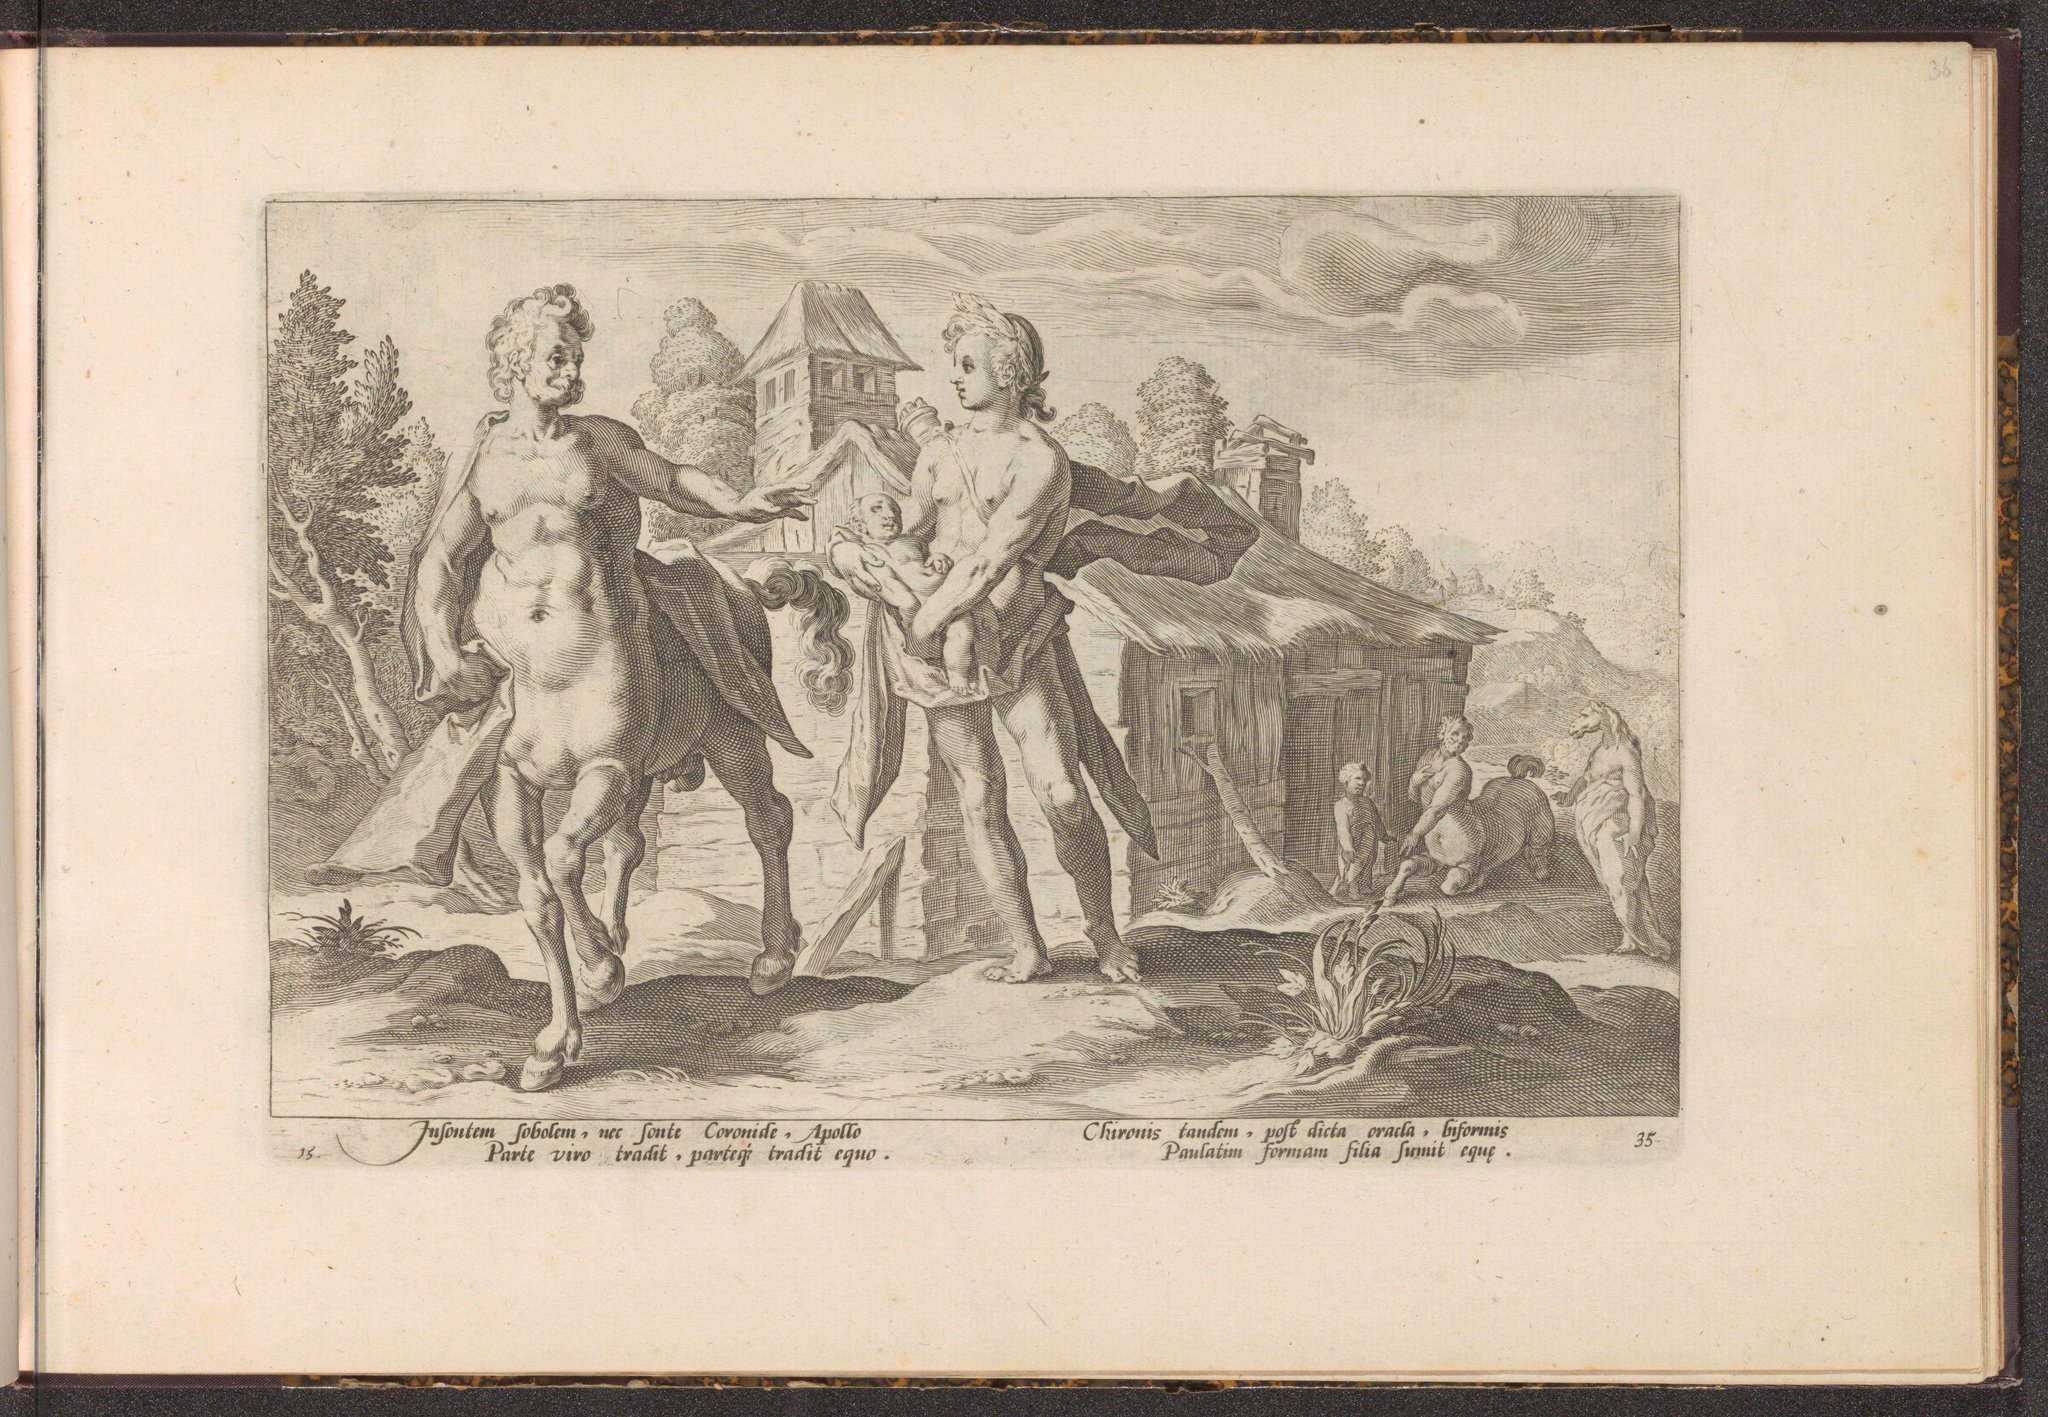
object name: album leaf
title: Herscheppingen van P. Ovidius Naso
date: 1590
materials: paper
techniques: engraving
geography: haarlem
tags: apollo hands aesculapius over to chiron, ocyroe changed into a mare: when she is foretelling the fates of her father chiron and the young aesculapius, ocyroe is changed into a mare (ovid, metamorphoses ii 657)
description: Apollo geeft zijn kind Asclepius, dat hij uit Coronis' buik heeft gesneden nadat hij haar heeft doodgeschoten, aan de centaur Chiron. Op de achtergrond is te zien hoe de dochter van Chiron in een paard verandert, na voorspeld te hebben hoe de toekomst van Asclepius en haar vader zal zijn. Onder de voorstelling twee keer twee versregels in het Latijn. De prent maakt deel uit van een album.